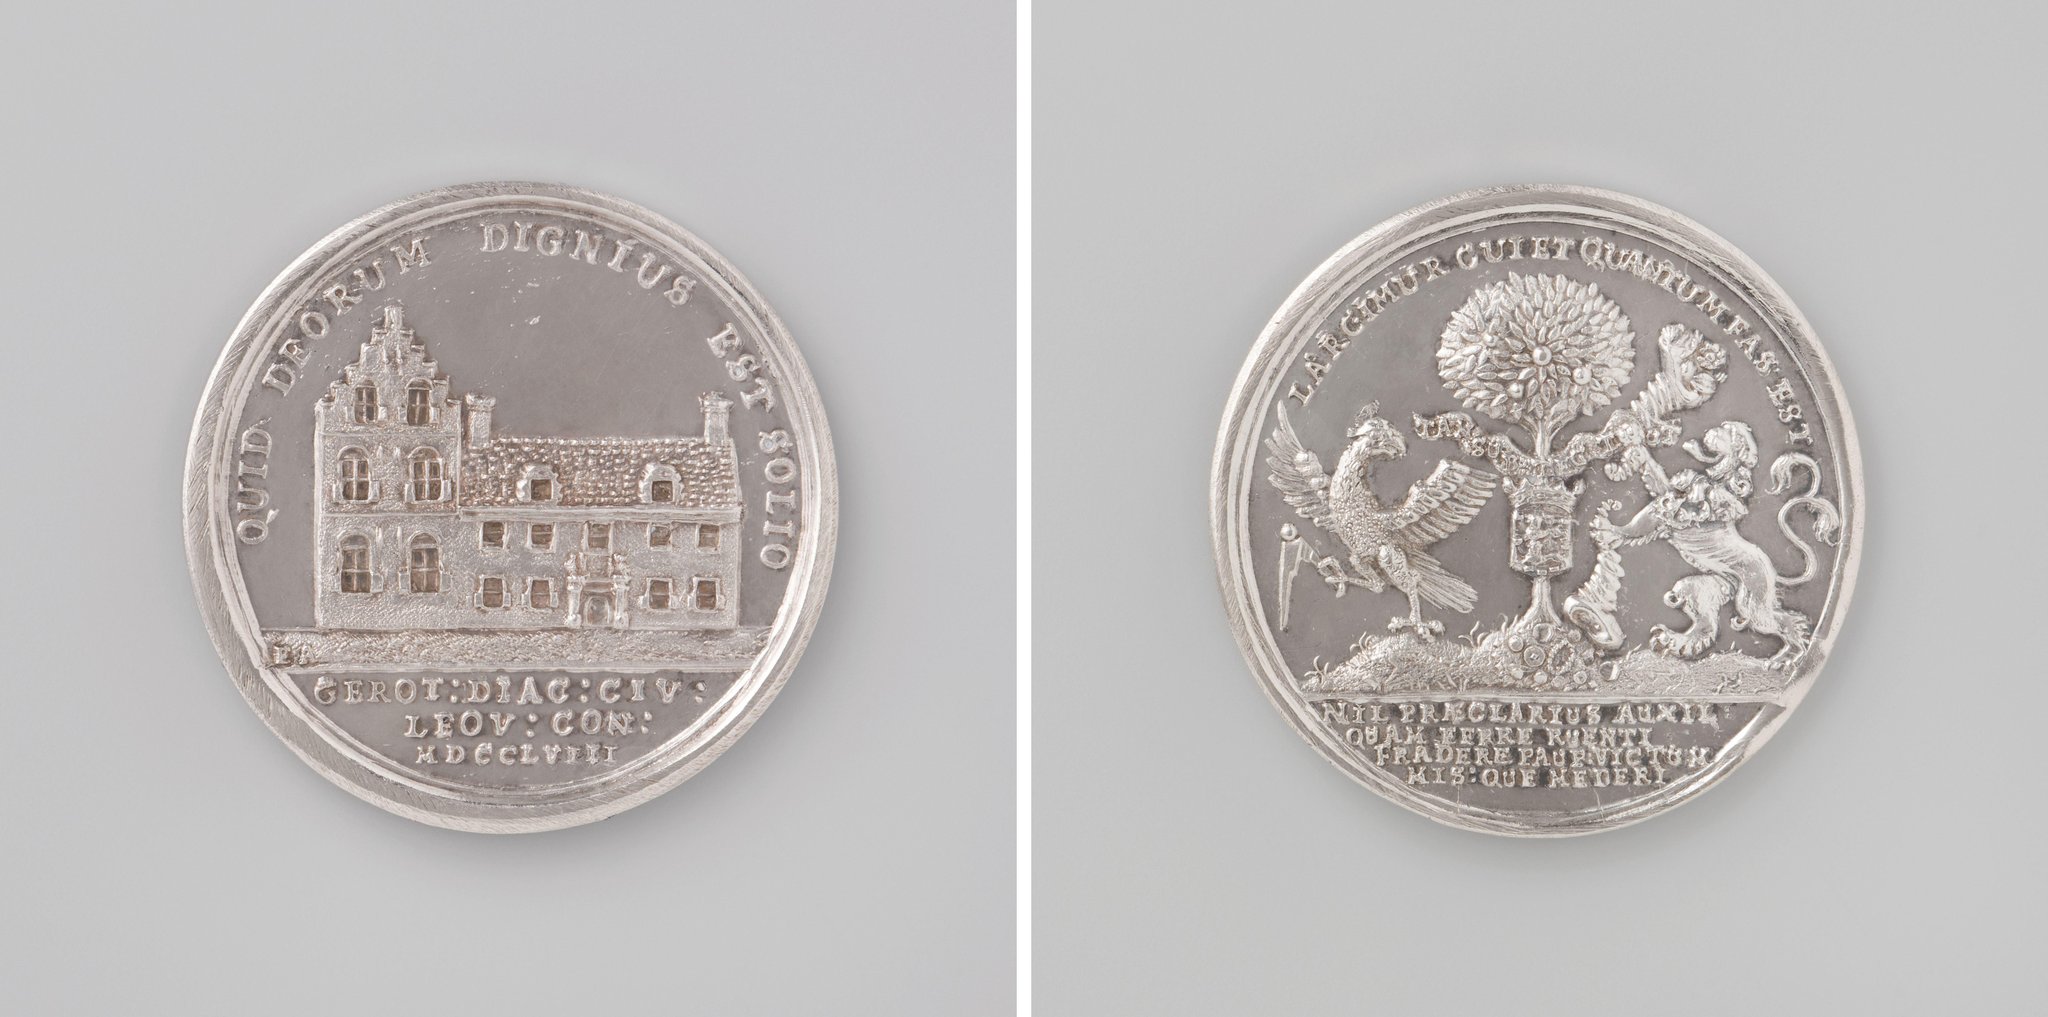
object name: history medal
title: Stichting van het oude mannen- en vrouwenhuis van de diaconie van de Nederduitsch Hervormde gemeente te Leeuwarden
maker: eise andeles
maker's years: 1731-1766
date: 1758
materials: silver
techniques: striking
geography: leeuwarden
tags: nederlands hervormde gemeente (amsterdam), leeuwarden